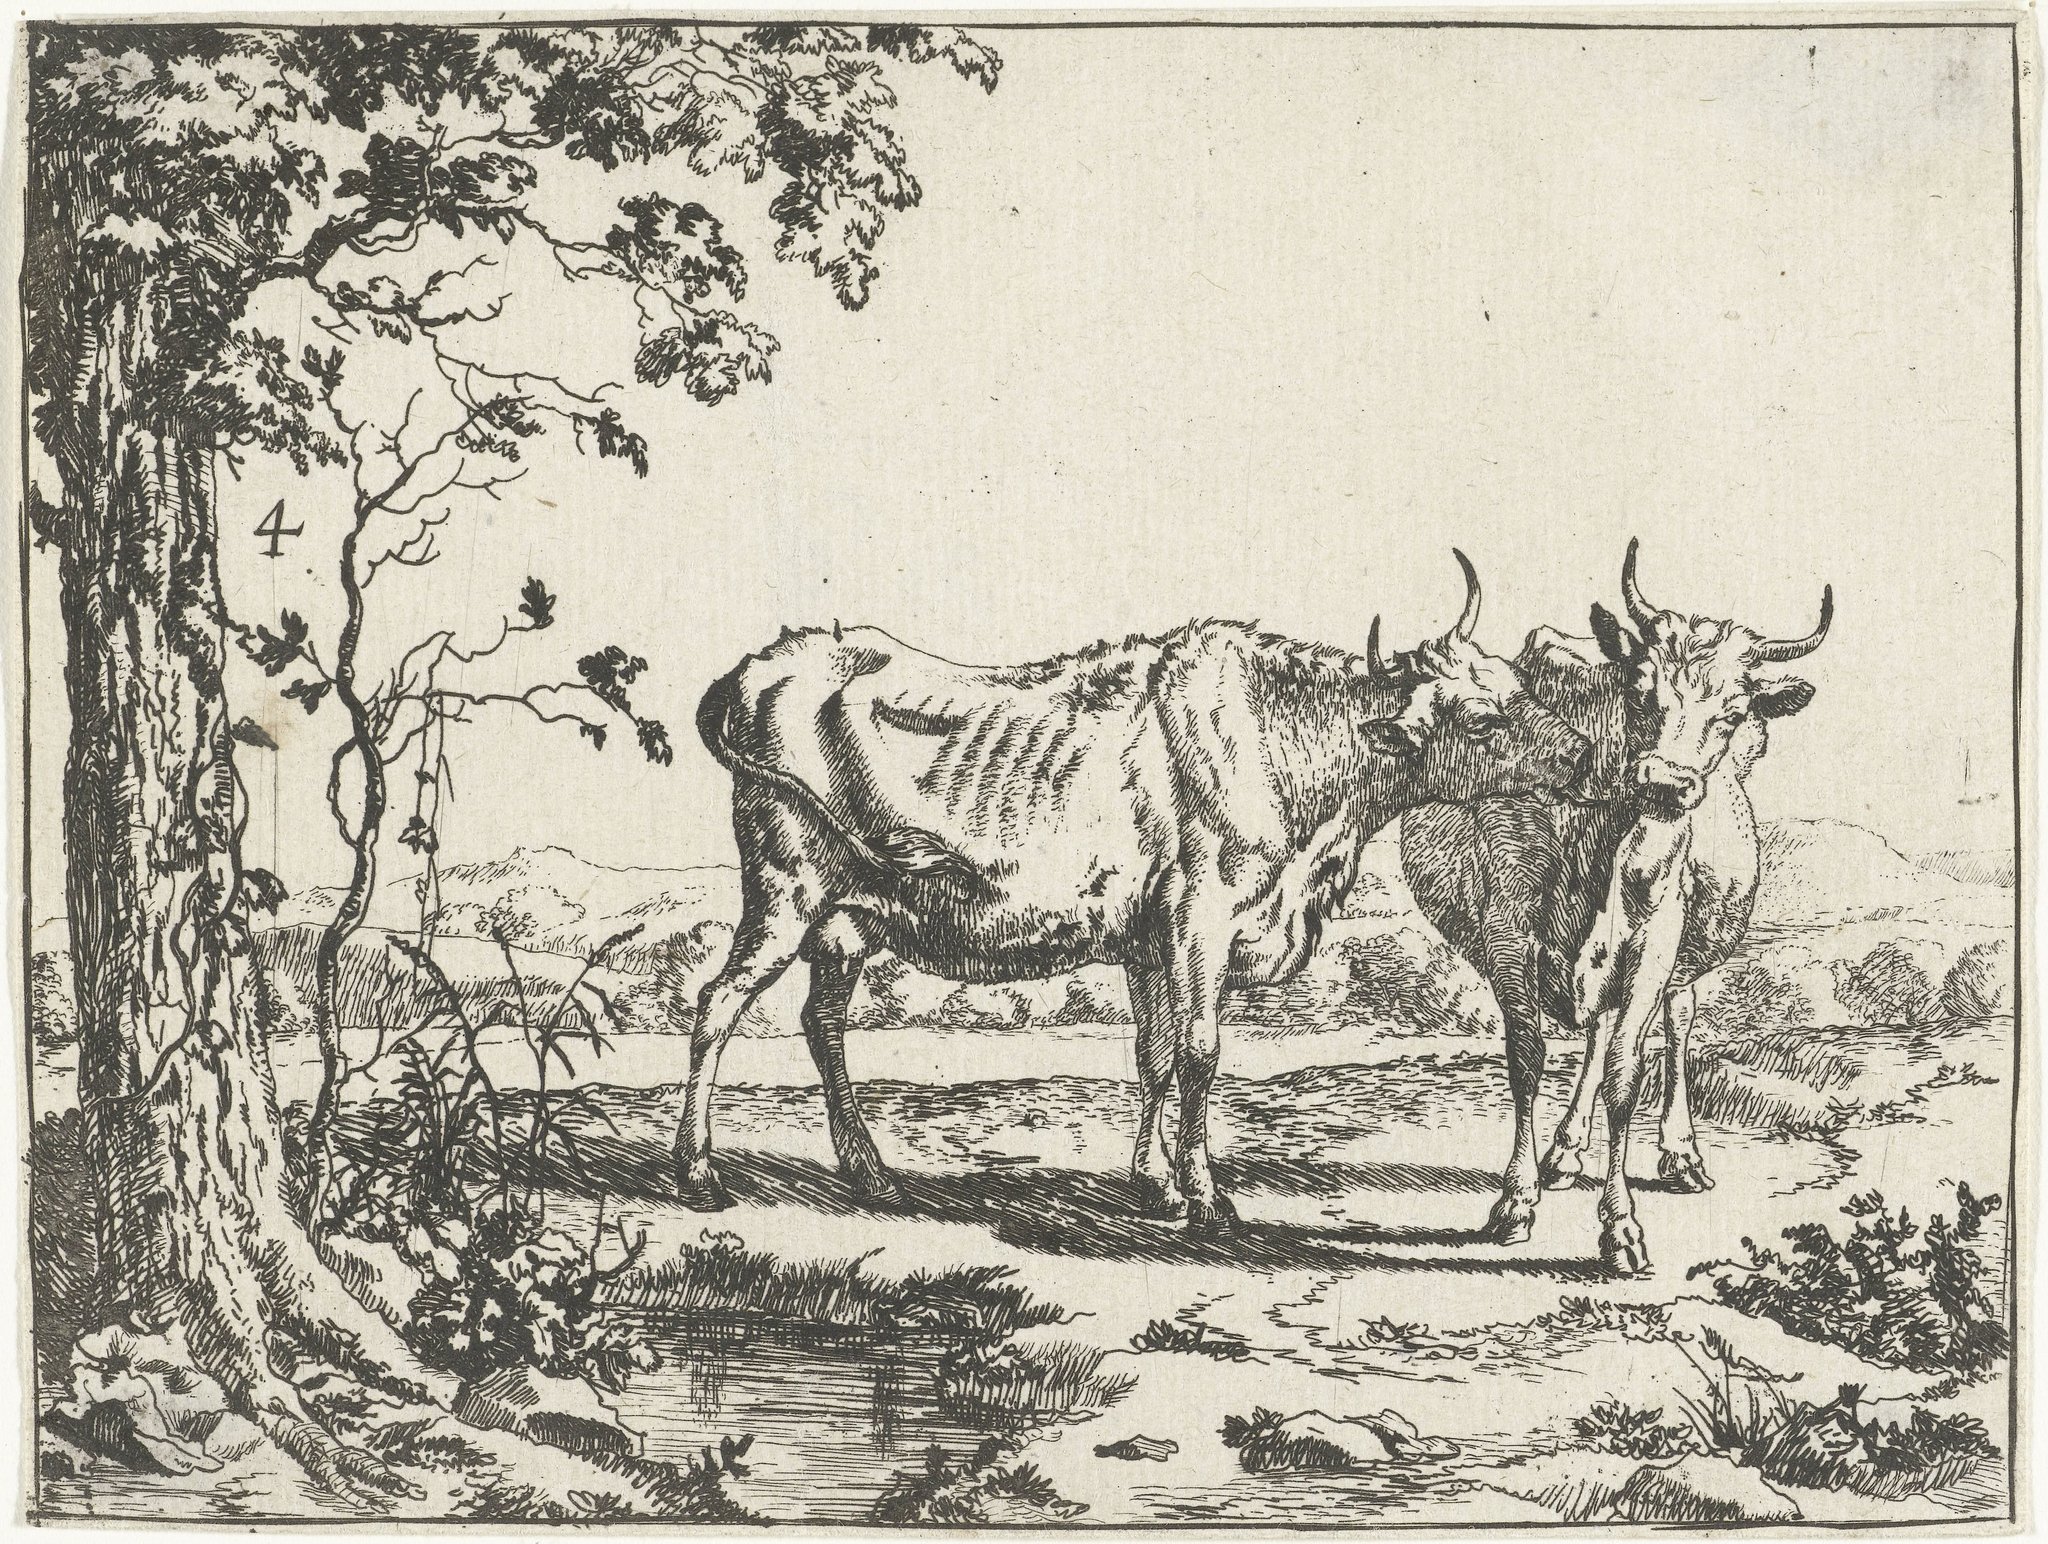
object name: print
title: Runderen en varkens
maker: marcus de bye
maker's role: print maker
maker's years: 1639-1688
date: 1657-1677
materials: paper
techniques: etching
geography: the hague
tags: cow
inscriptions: collector's mark: Lugt 2228